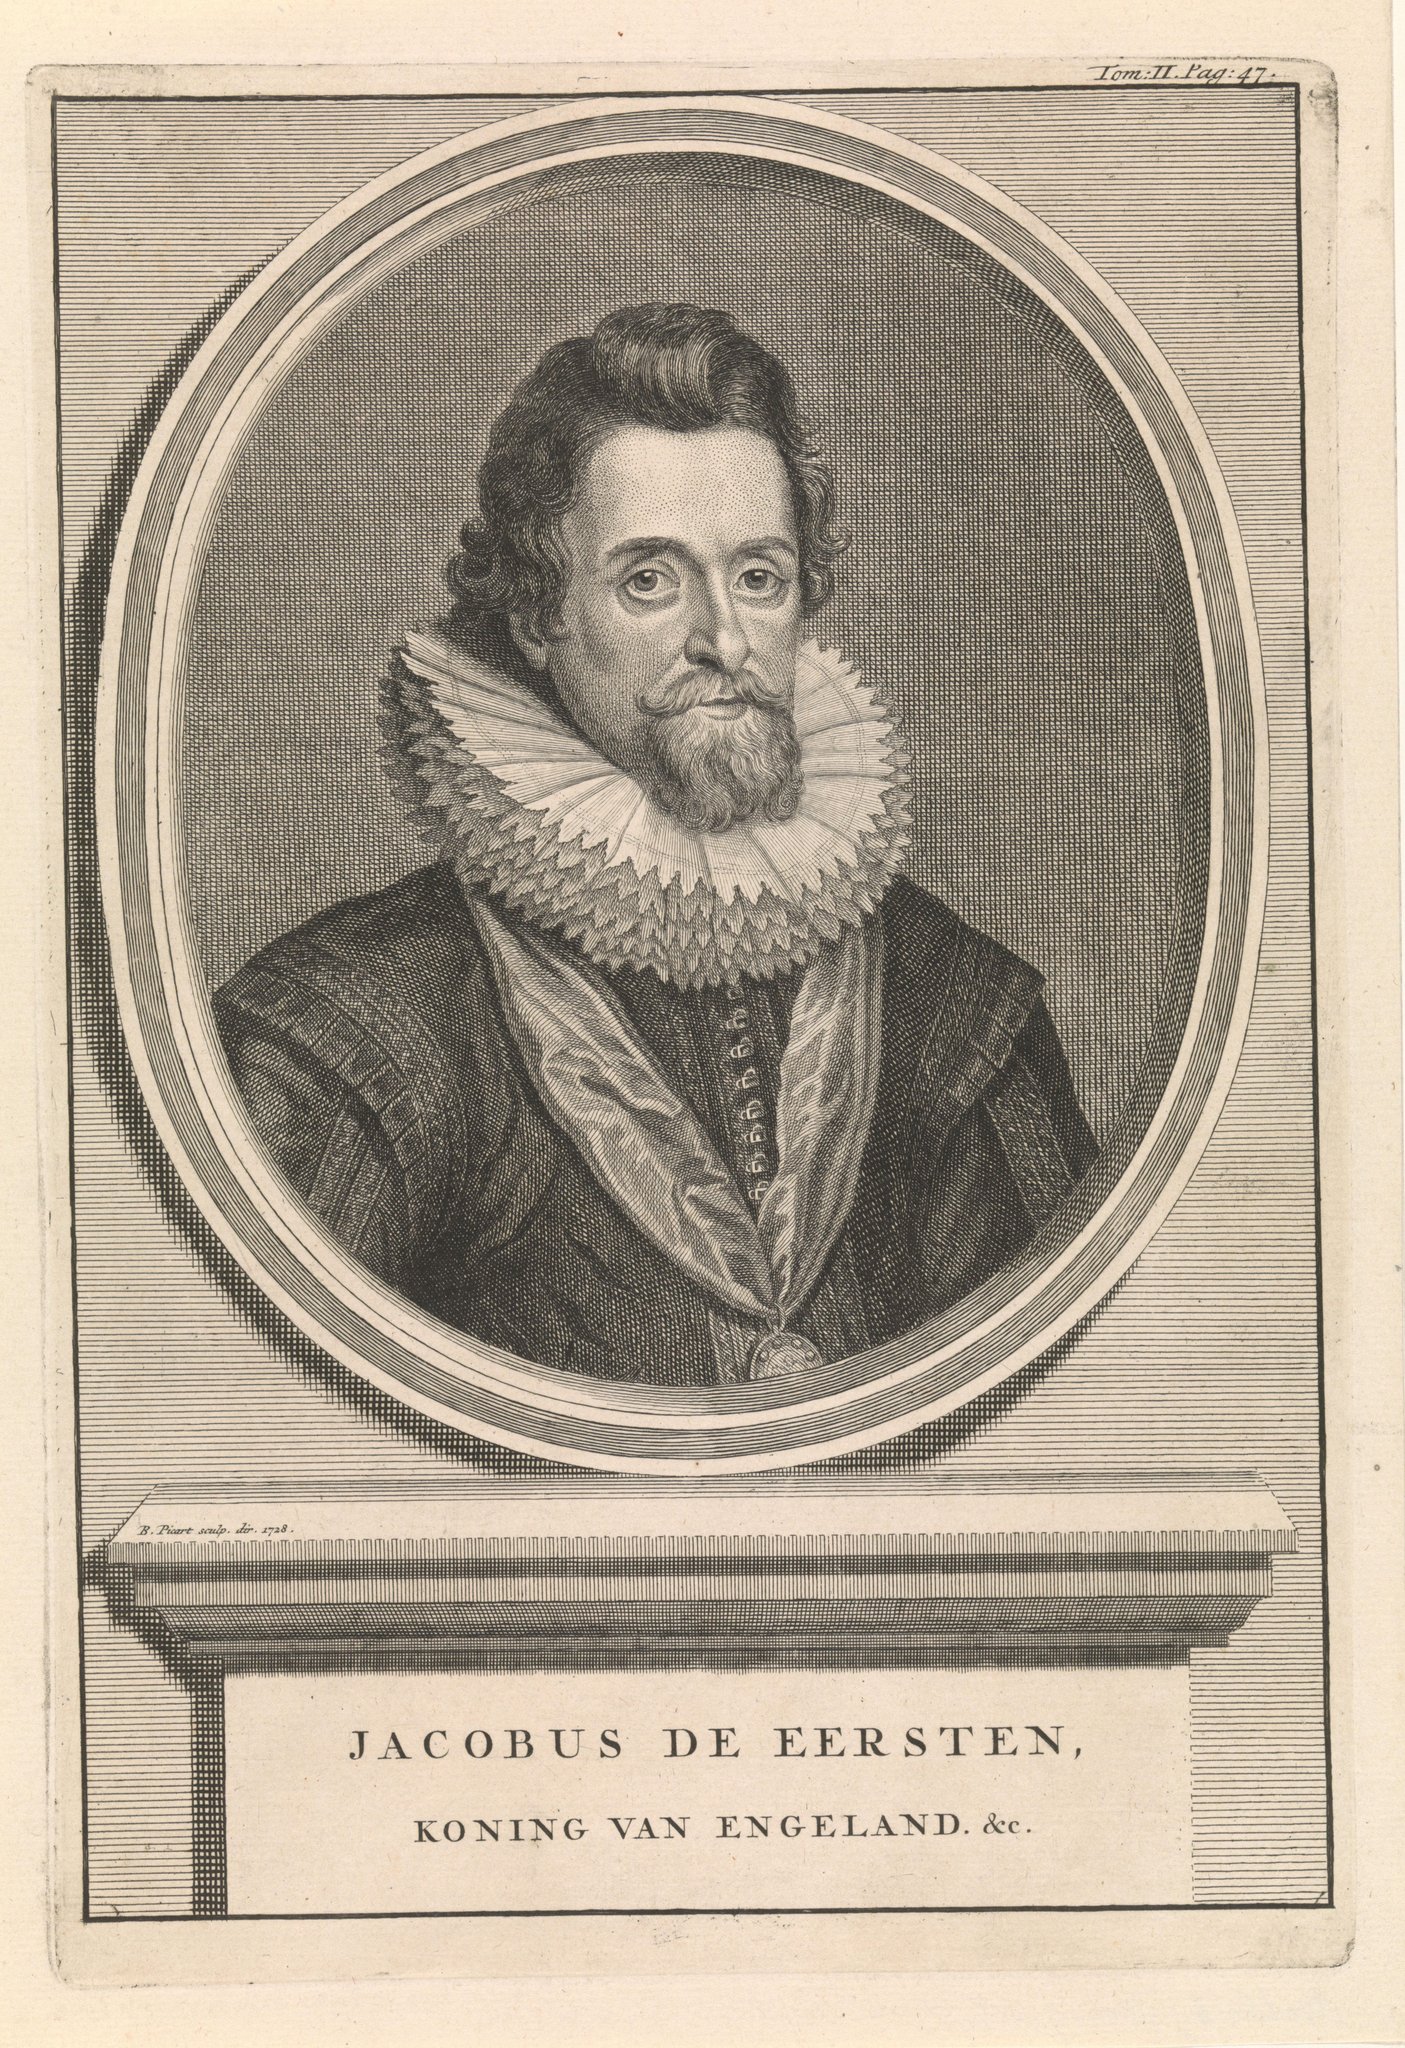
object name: book illustration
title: Portret van Jacobus I, koning van Engeland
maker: bernard picart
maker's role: draughtsman, print maker, publisher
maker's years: 1673-1733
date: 1728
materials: paper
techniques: engraving, etching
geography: amsterdam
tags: jacobus i (koning van engeland)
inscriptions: collector's mark: Lugt 2228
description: Prent als illustratie gebruikt in: Le Clerc, Jean. Geschiedenissen der Vereenigde Nederlanden. Amsterdam: Zacharias Chatelain (II), 1730.